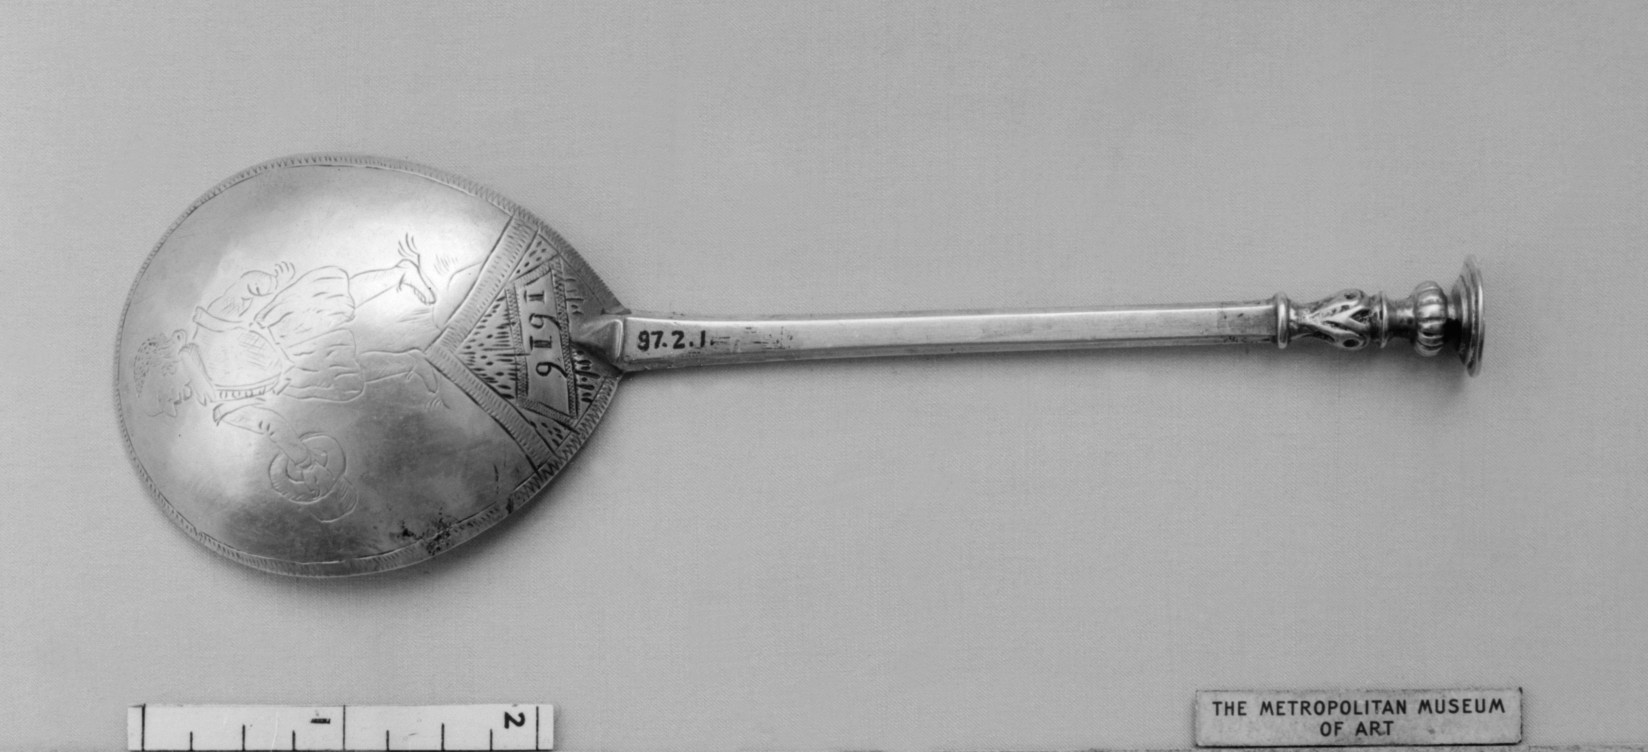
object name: spoon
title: Seal-top spoon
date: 1601-1633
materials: gilt, silver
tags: men